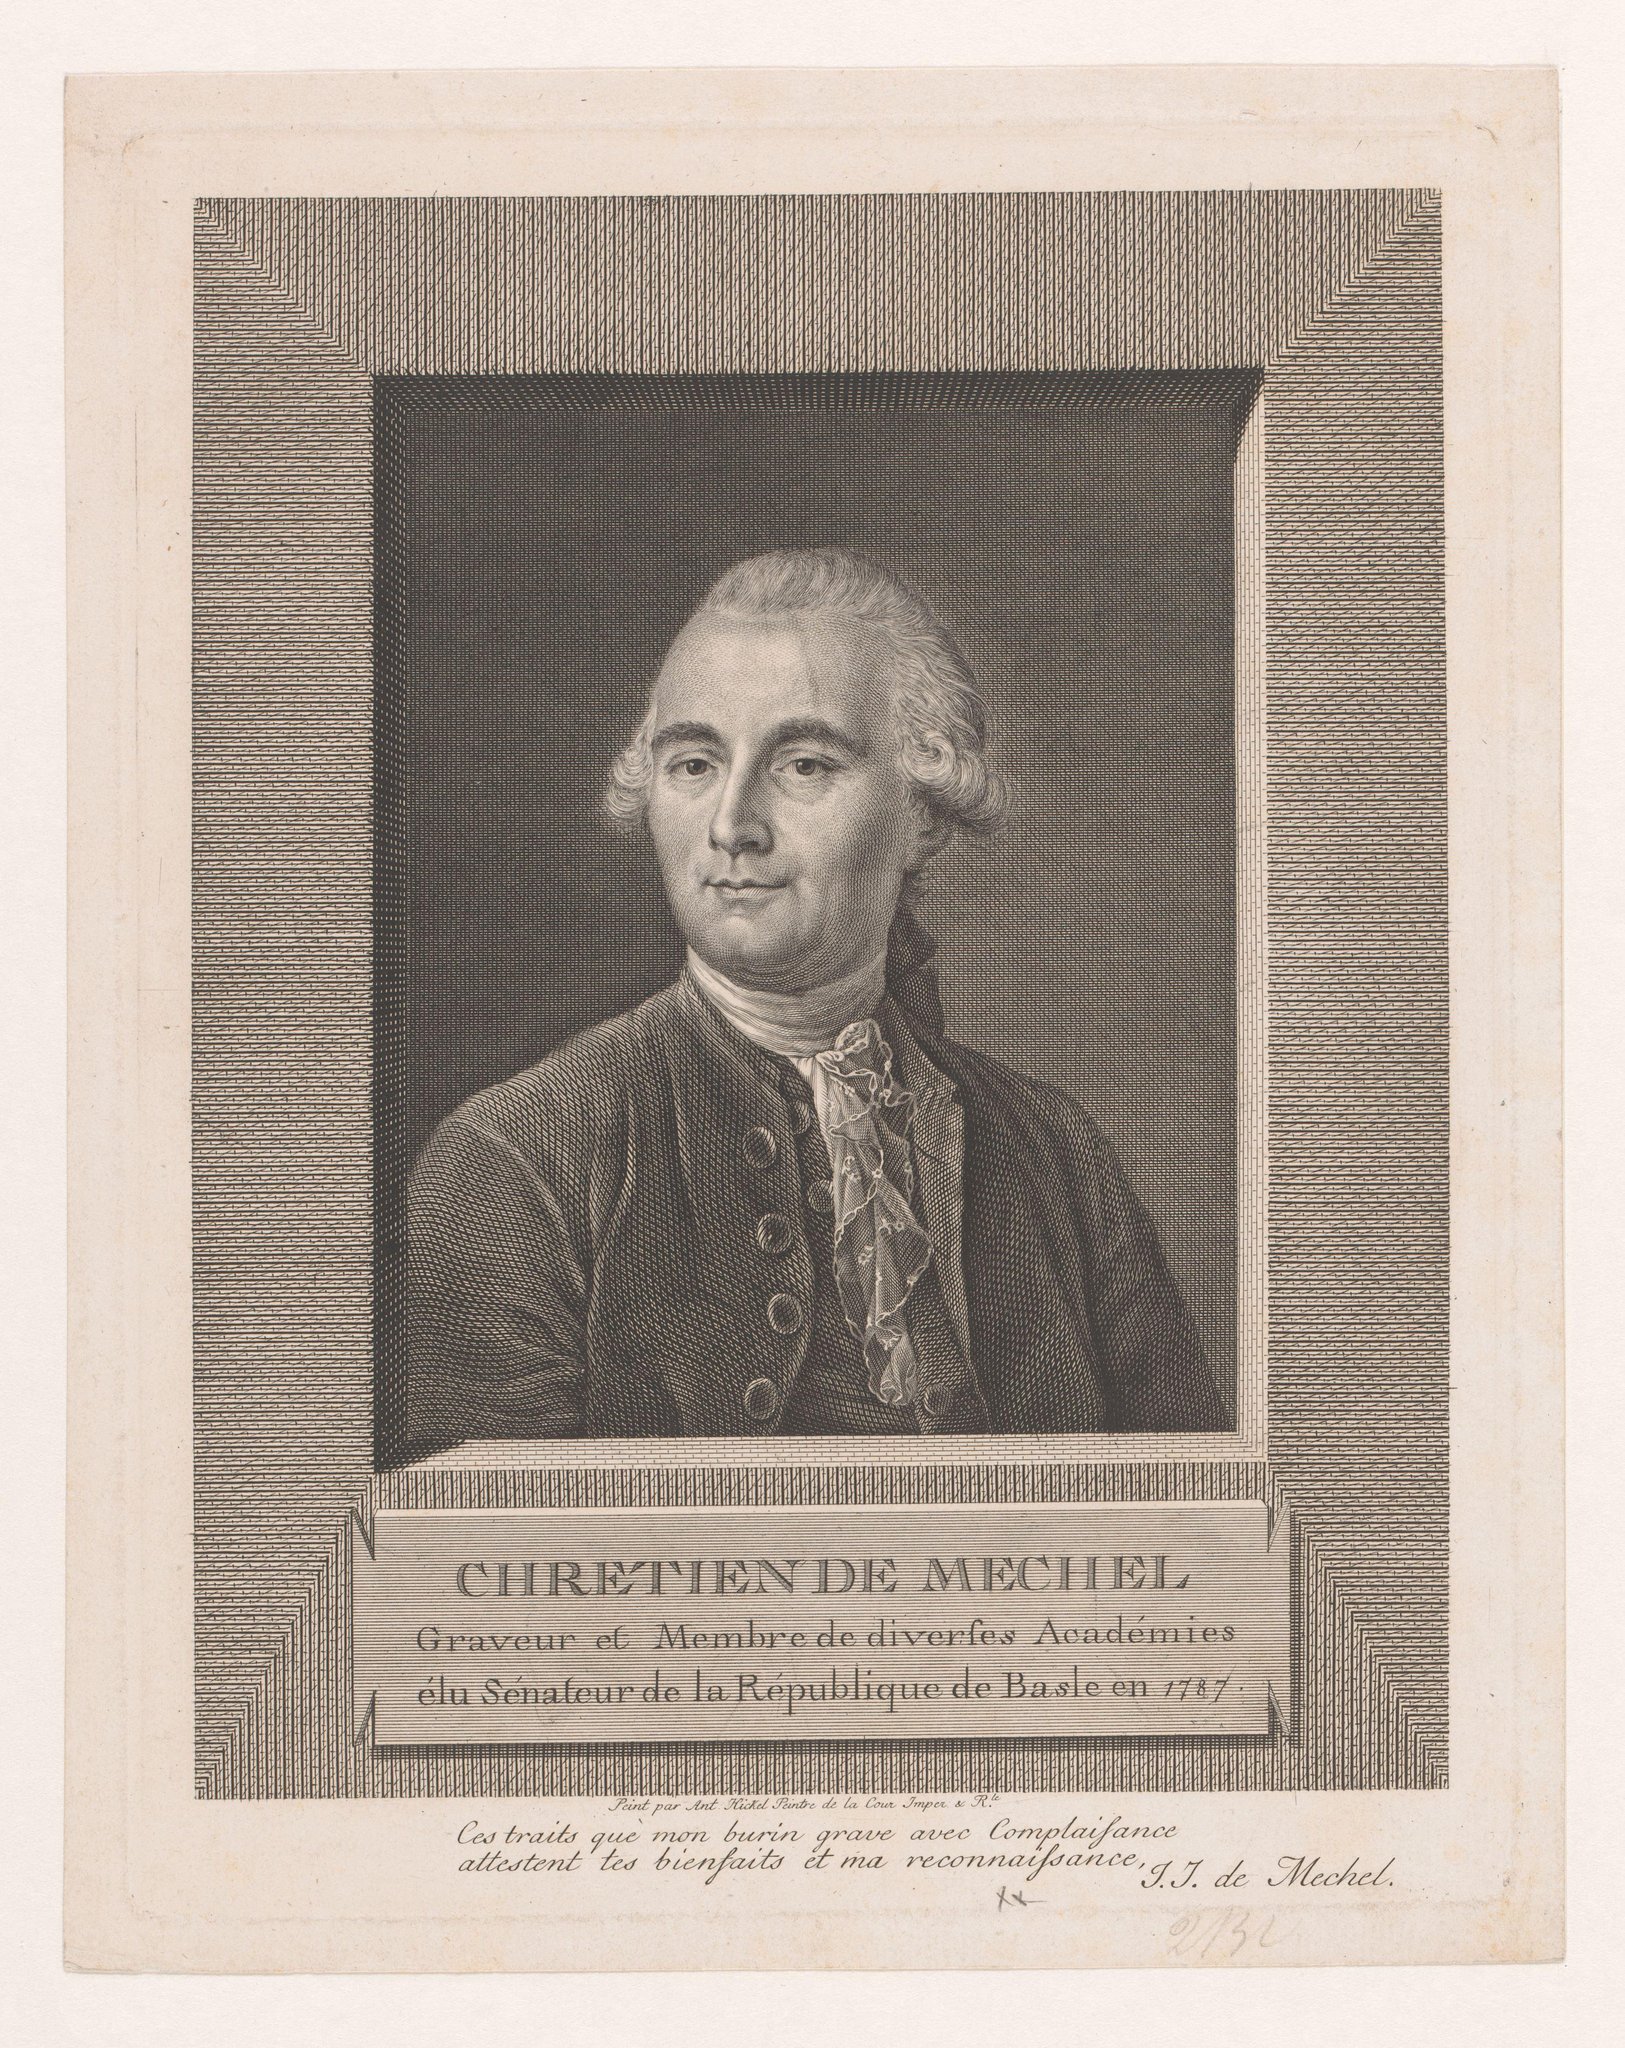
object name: print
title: Portret van Christian von Mechel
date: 1787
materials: paper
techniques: engraving, etching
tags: publisher, christian von mechel, portrait, self-portrait of graphic artist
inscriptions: collector's mark: Lugt 2228